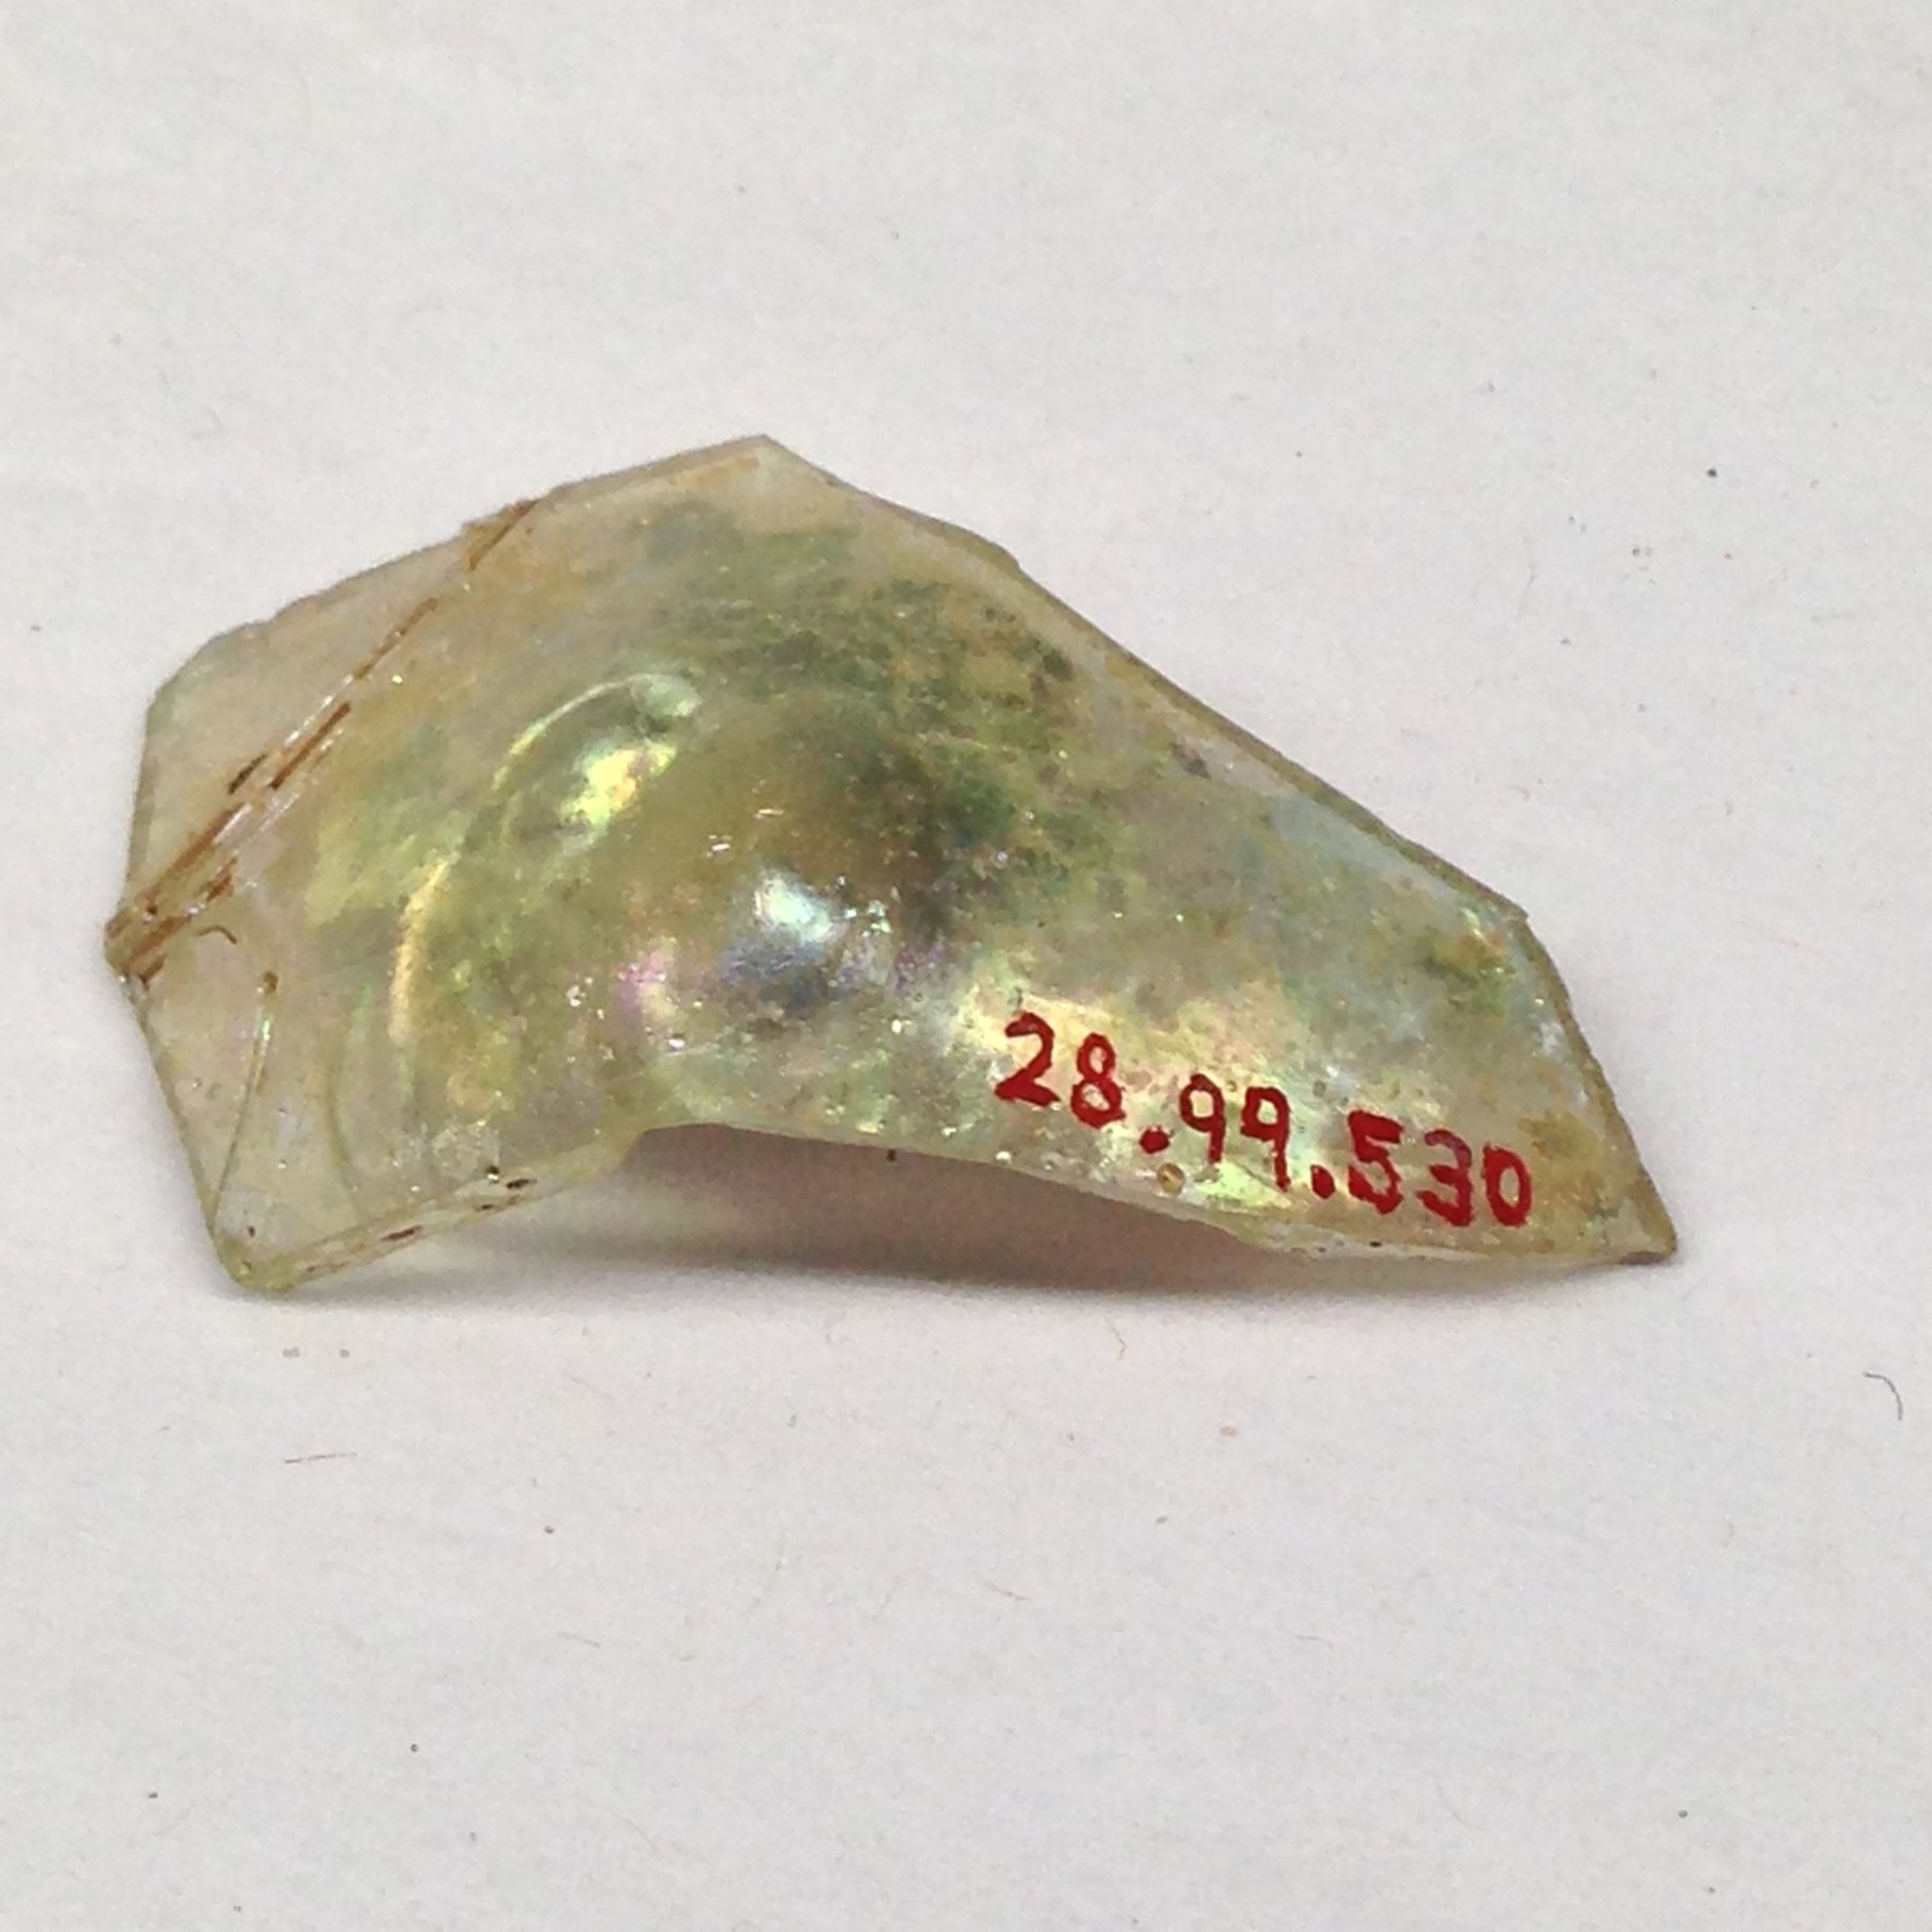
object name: fragment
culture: european or middle eastern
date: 1150-1250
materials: ceramic, glass